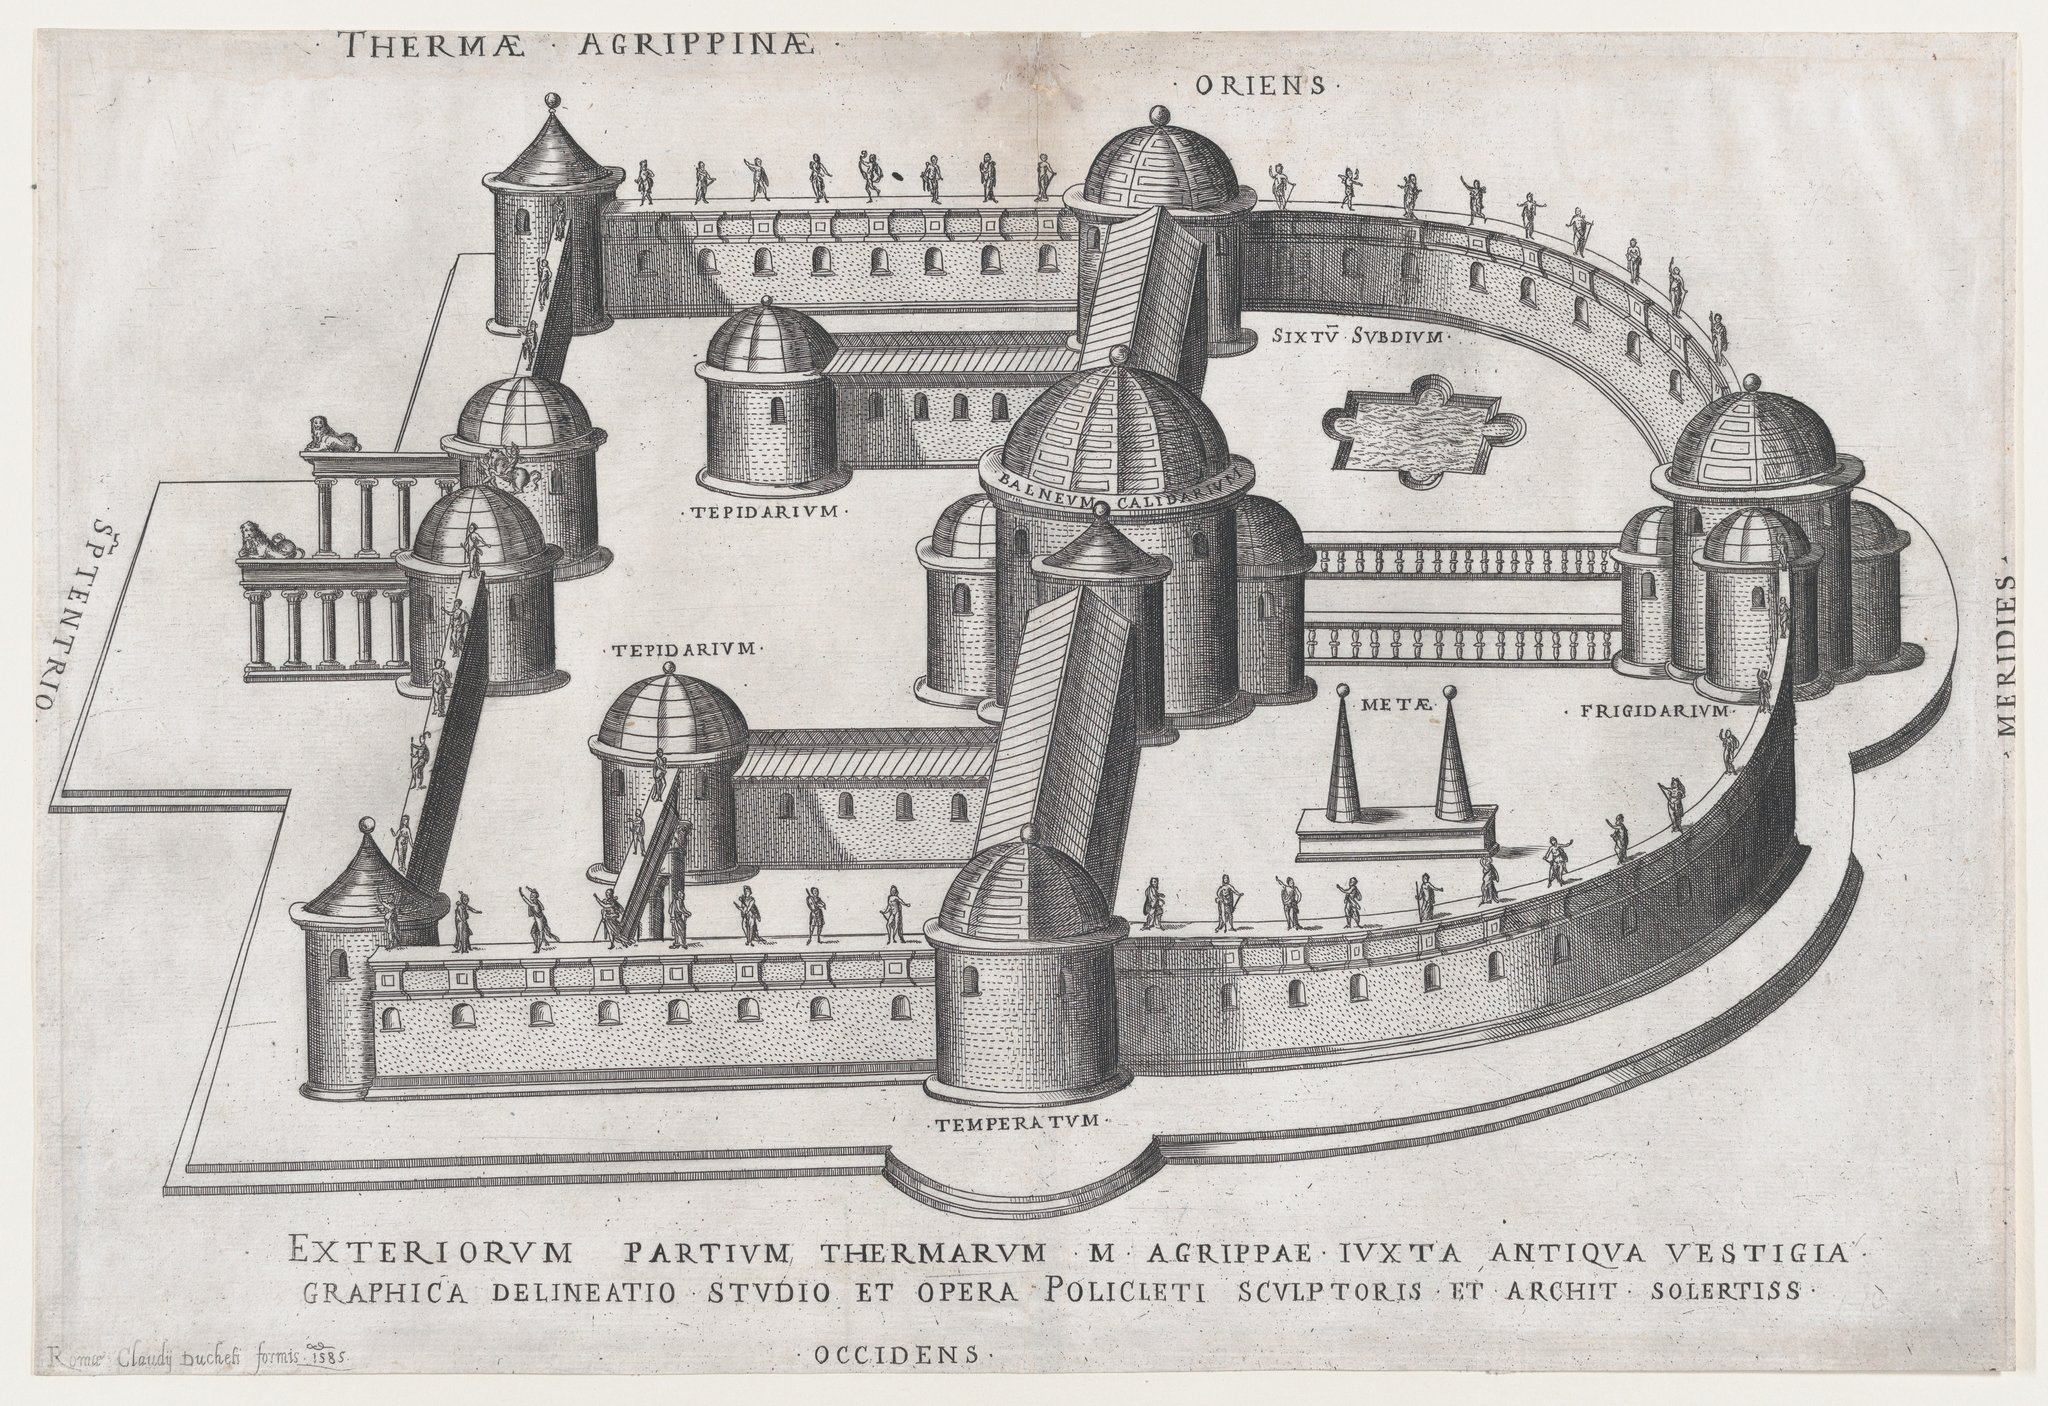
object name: print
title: Baths of Agrippa, from "Speculum Romanae Magnificentiae"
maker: Anonymous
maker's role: artist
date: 1585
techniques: engraving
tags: architecture,rome